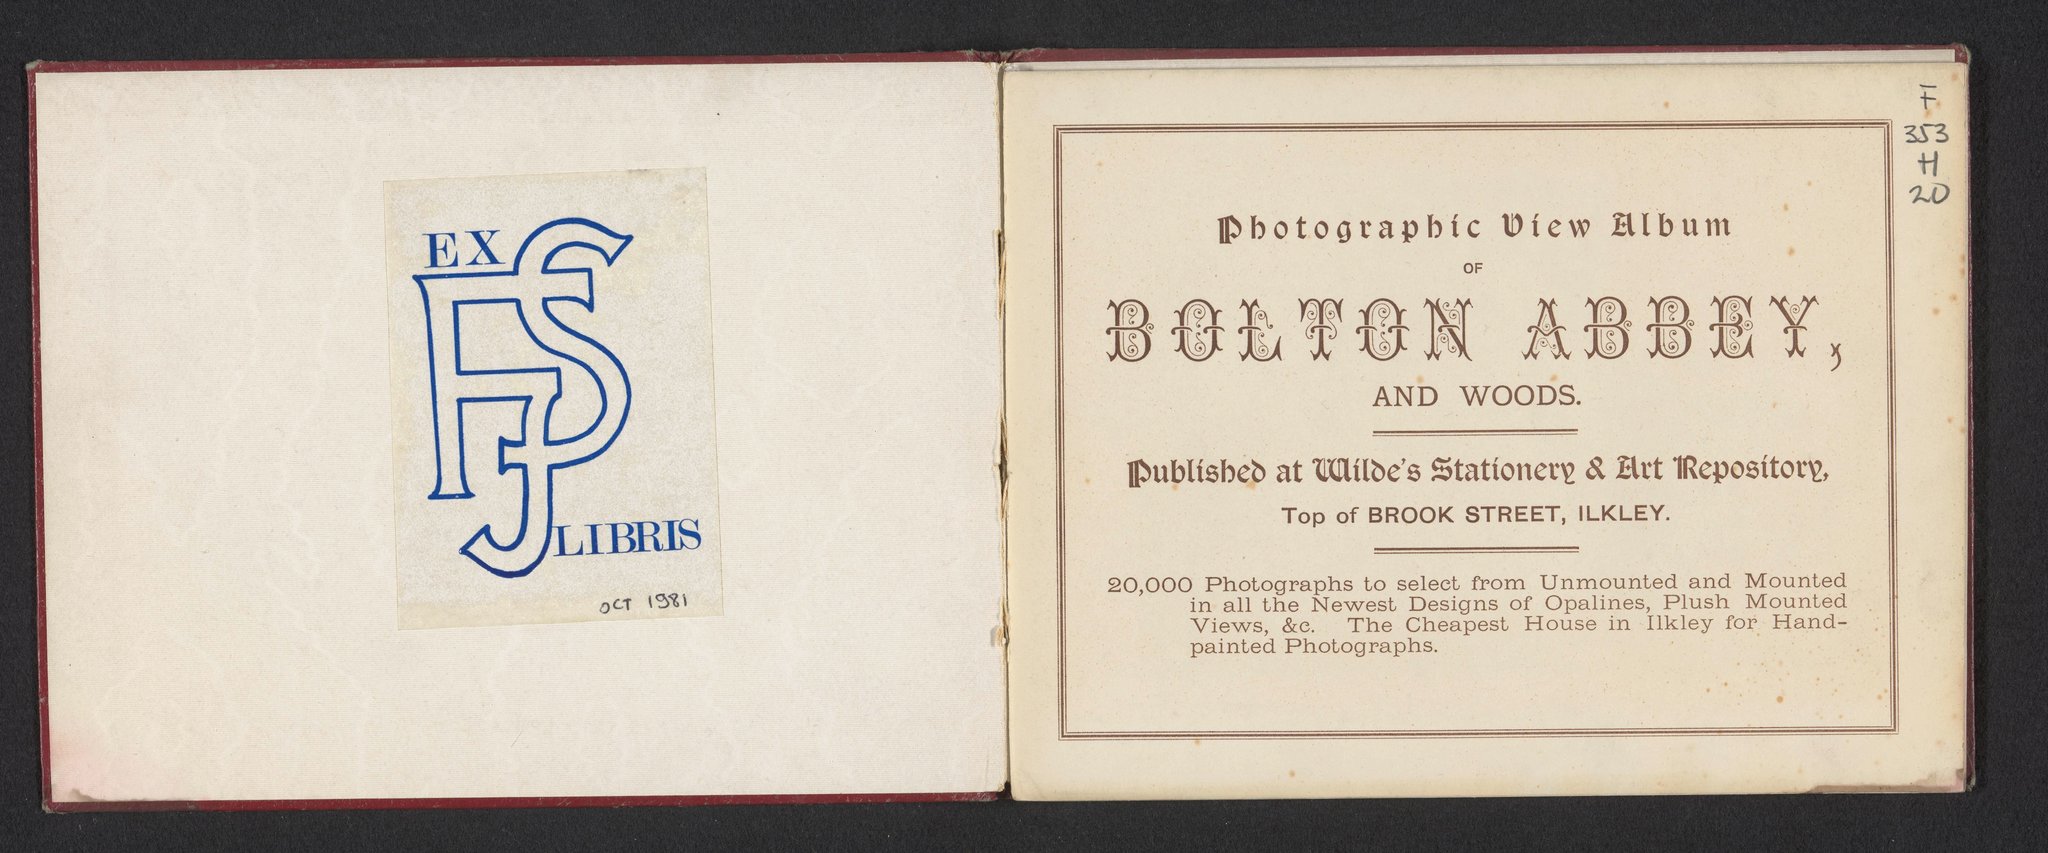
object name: book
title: Photographic view album of Bolton Abbey and woods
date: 1900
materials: cardboard, linen, paper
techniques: photograph, printing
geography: ilkley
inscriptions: inscription: ‘ex libris SFJ’